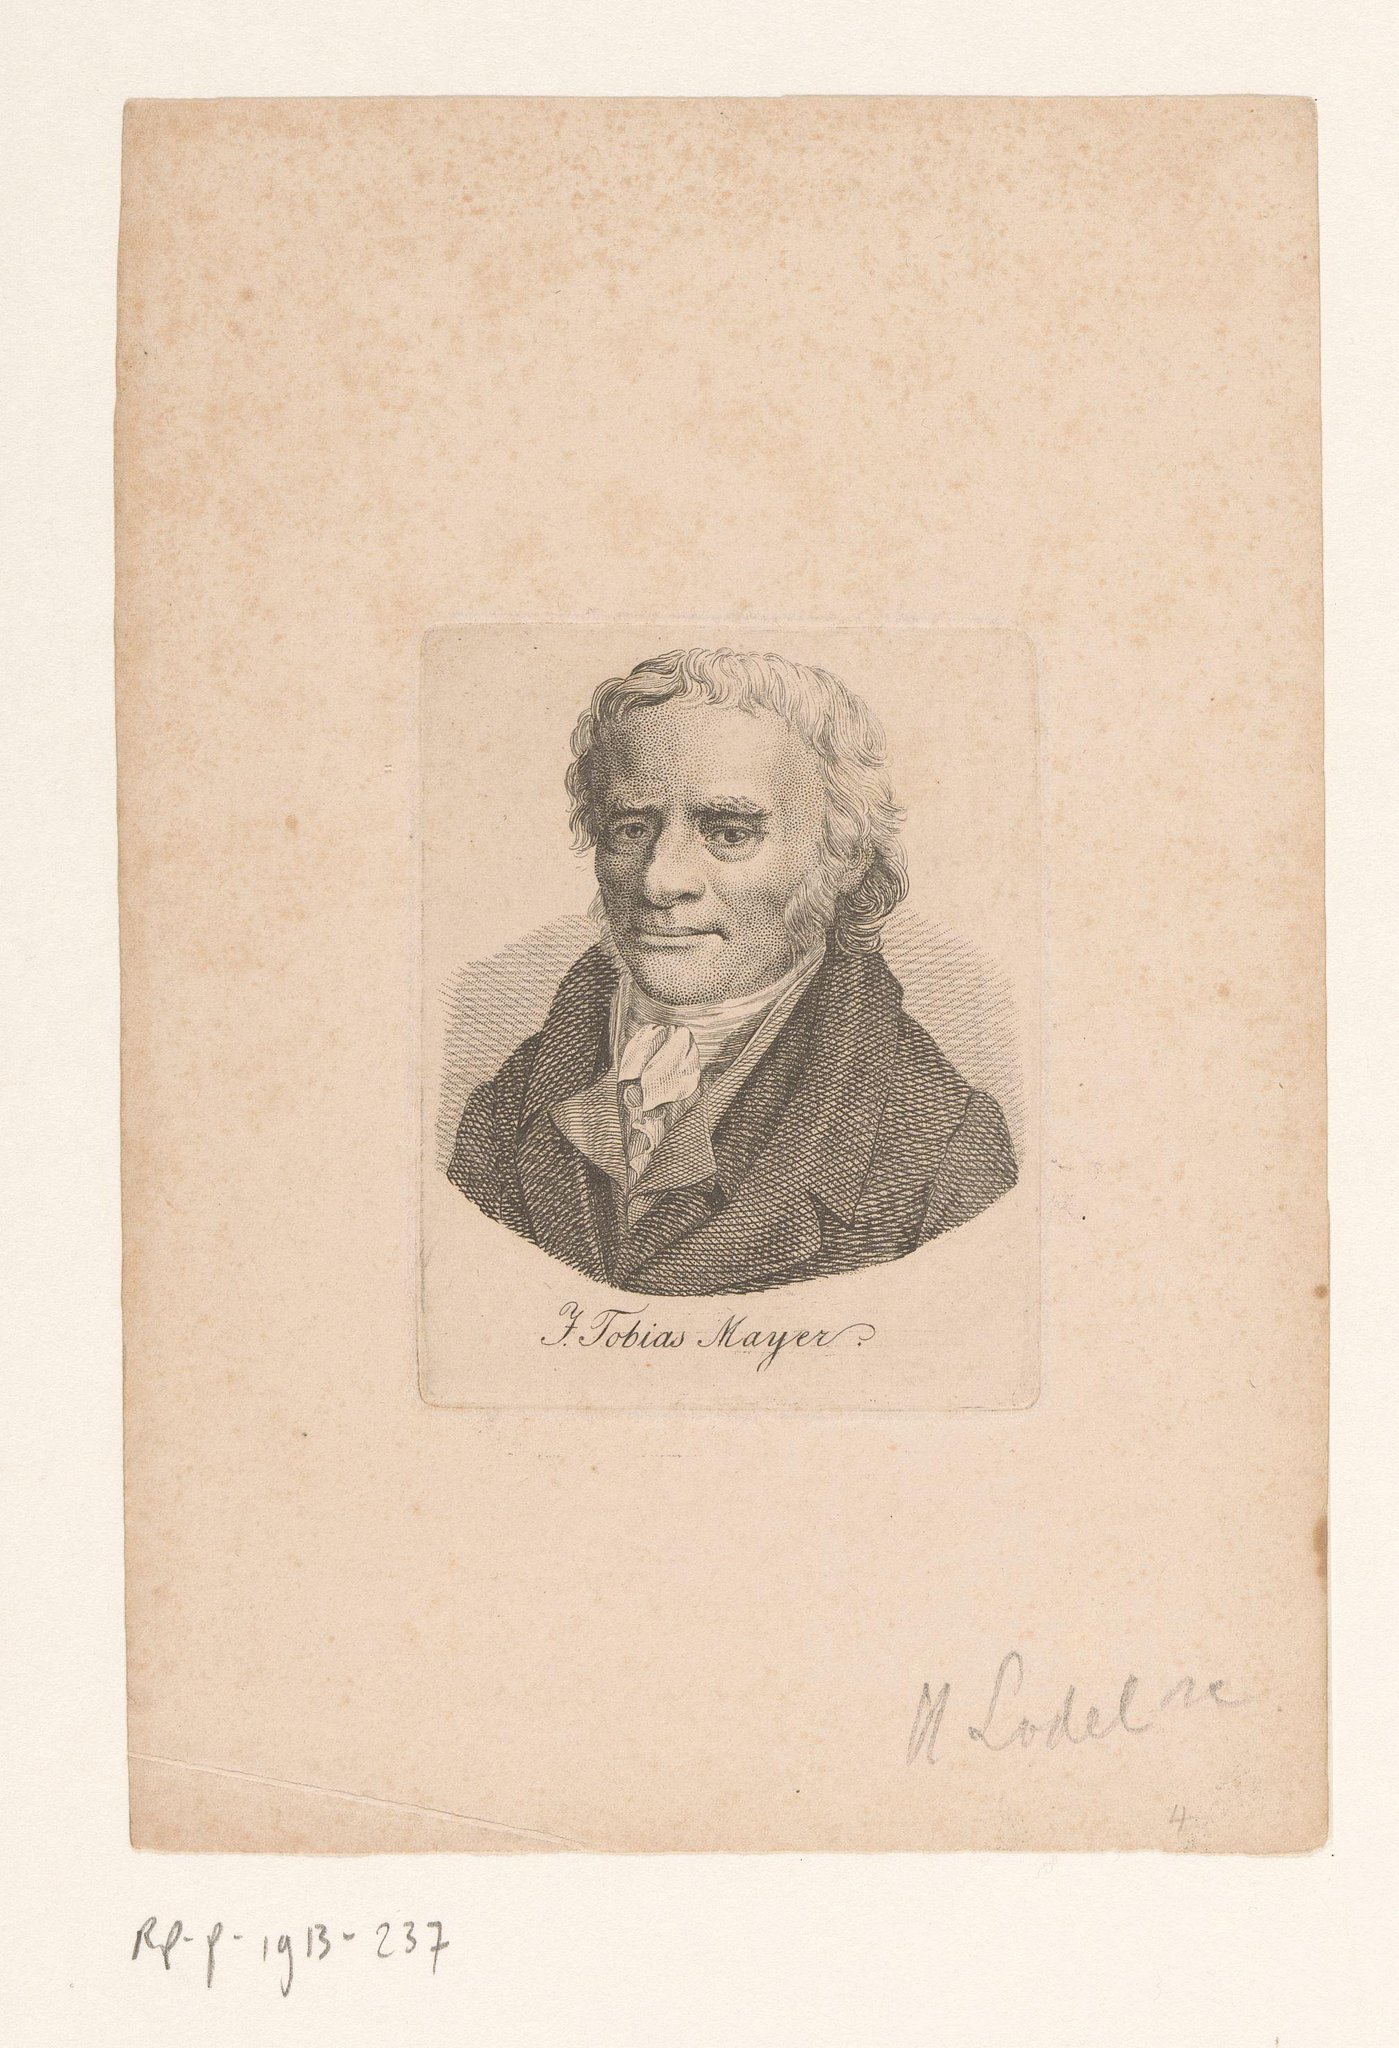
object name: print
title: Portret van Johann Tobias Mayer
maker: heinrich lödel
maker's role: print maker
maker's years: 1798-1861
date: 1808-1861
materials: paper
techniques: engraving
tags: physicist, historical persons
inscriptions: collector's mark: Lugt 2228, name